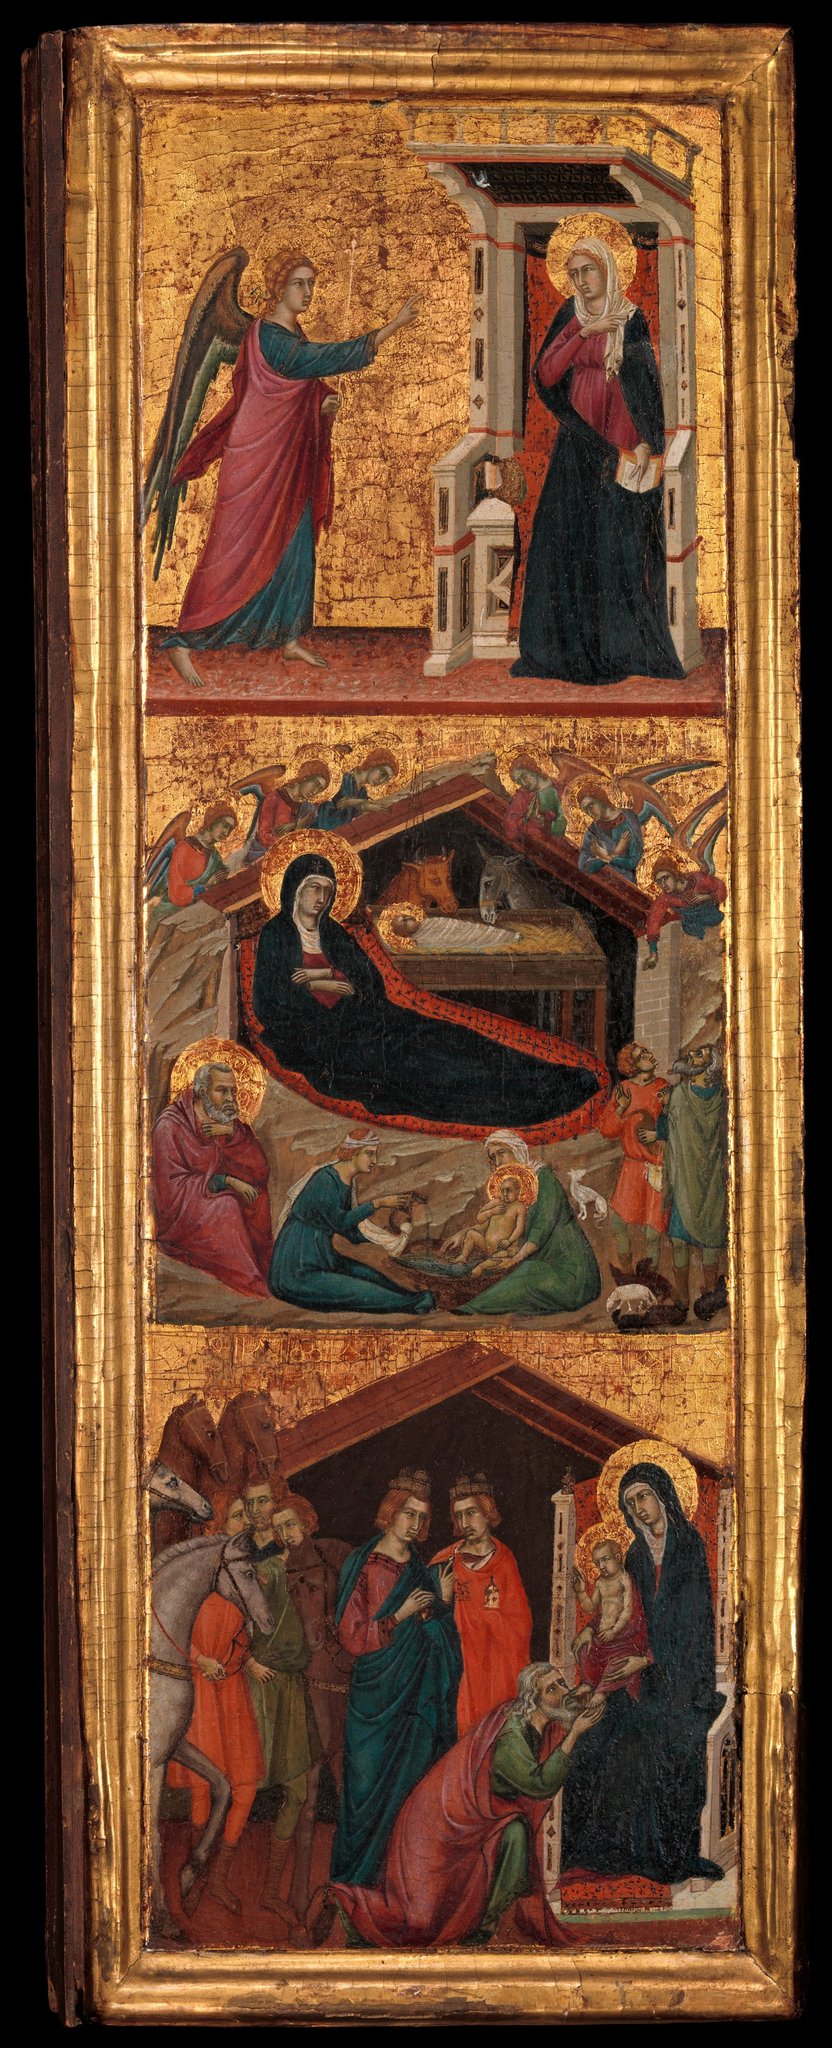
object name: painting, wing of a triptych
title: Saints and Scenes from the Life of the Virgin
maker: master of monte oliveto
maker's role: artist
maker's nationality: italian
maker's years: 1305-1335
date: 1320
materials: gold leaf, paint, wood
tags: mary magdalene,saint john the baptist,virgin mary,archangel gabriel,adoration of the magi,adoration of the shepherds,annunciation,nativity